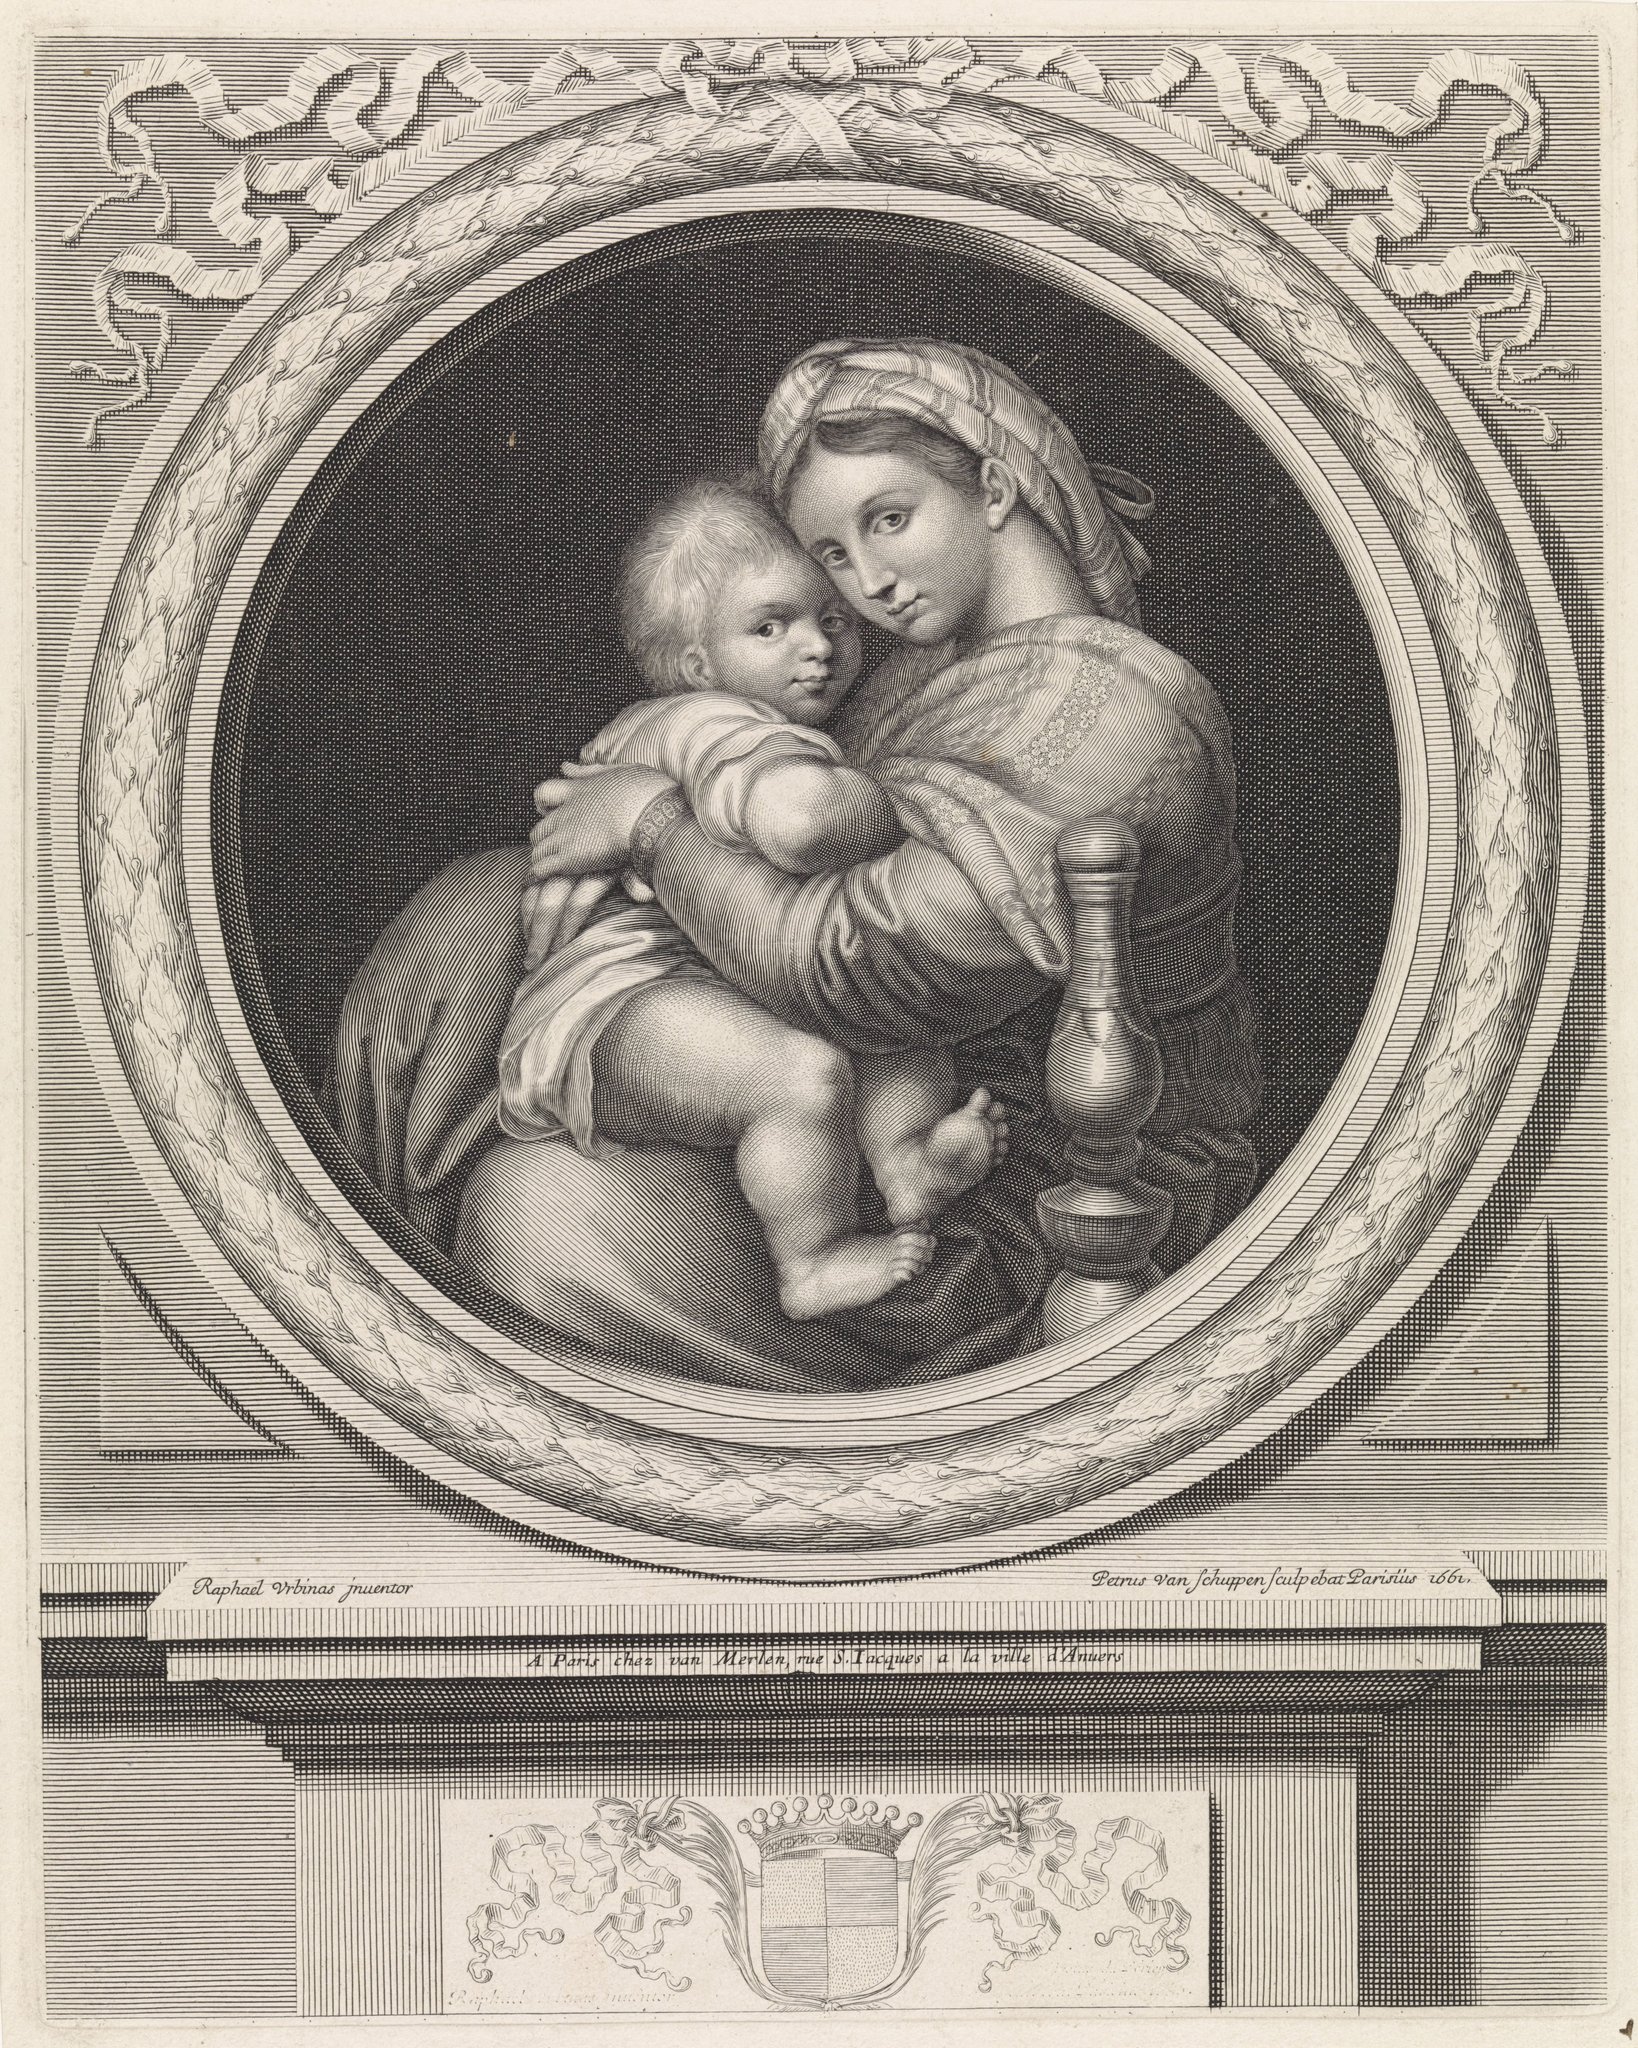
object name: print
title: Madonna della Sedia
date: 1661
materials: paper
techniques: engraving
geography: paris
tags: mary sitting or enthroned, the christ-child sitting on her knee (christ-child to mary's left) - ff - the christ-child to mary's right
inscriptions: collector's mark: Lugt 11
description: Maria met het Christuskind op schoot. Op een piëdestal onderaan staat een (niet ingevuld) wapenschild.